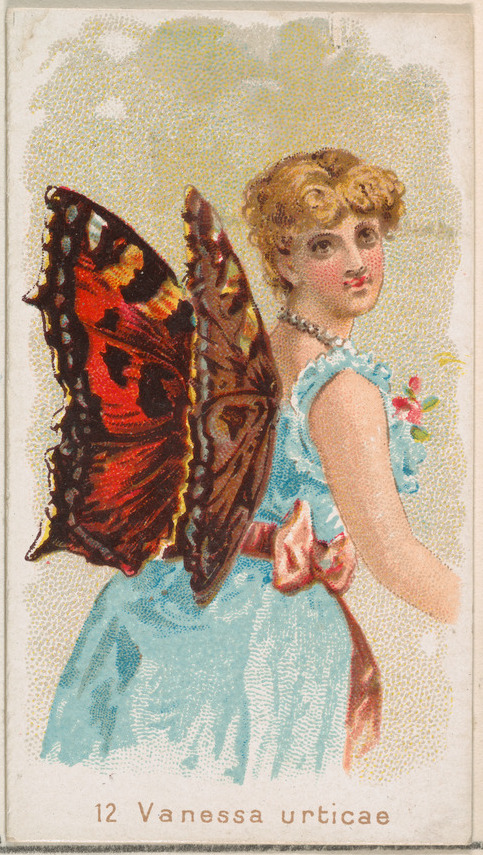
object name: print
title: Card 12, Vanessa Urticae, from the Butterflies series (N183) issued by Wm. S. Kimball & Co.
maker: william s. kimball & company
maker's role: publisher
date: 1888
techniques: color lithograph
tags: women,butterflies